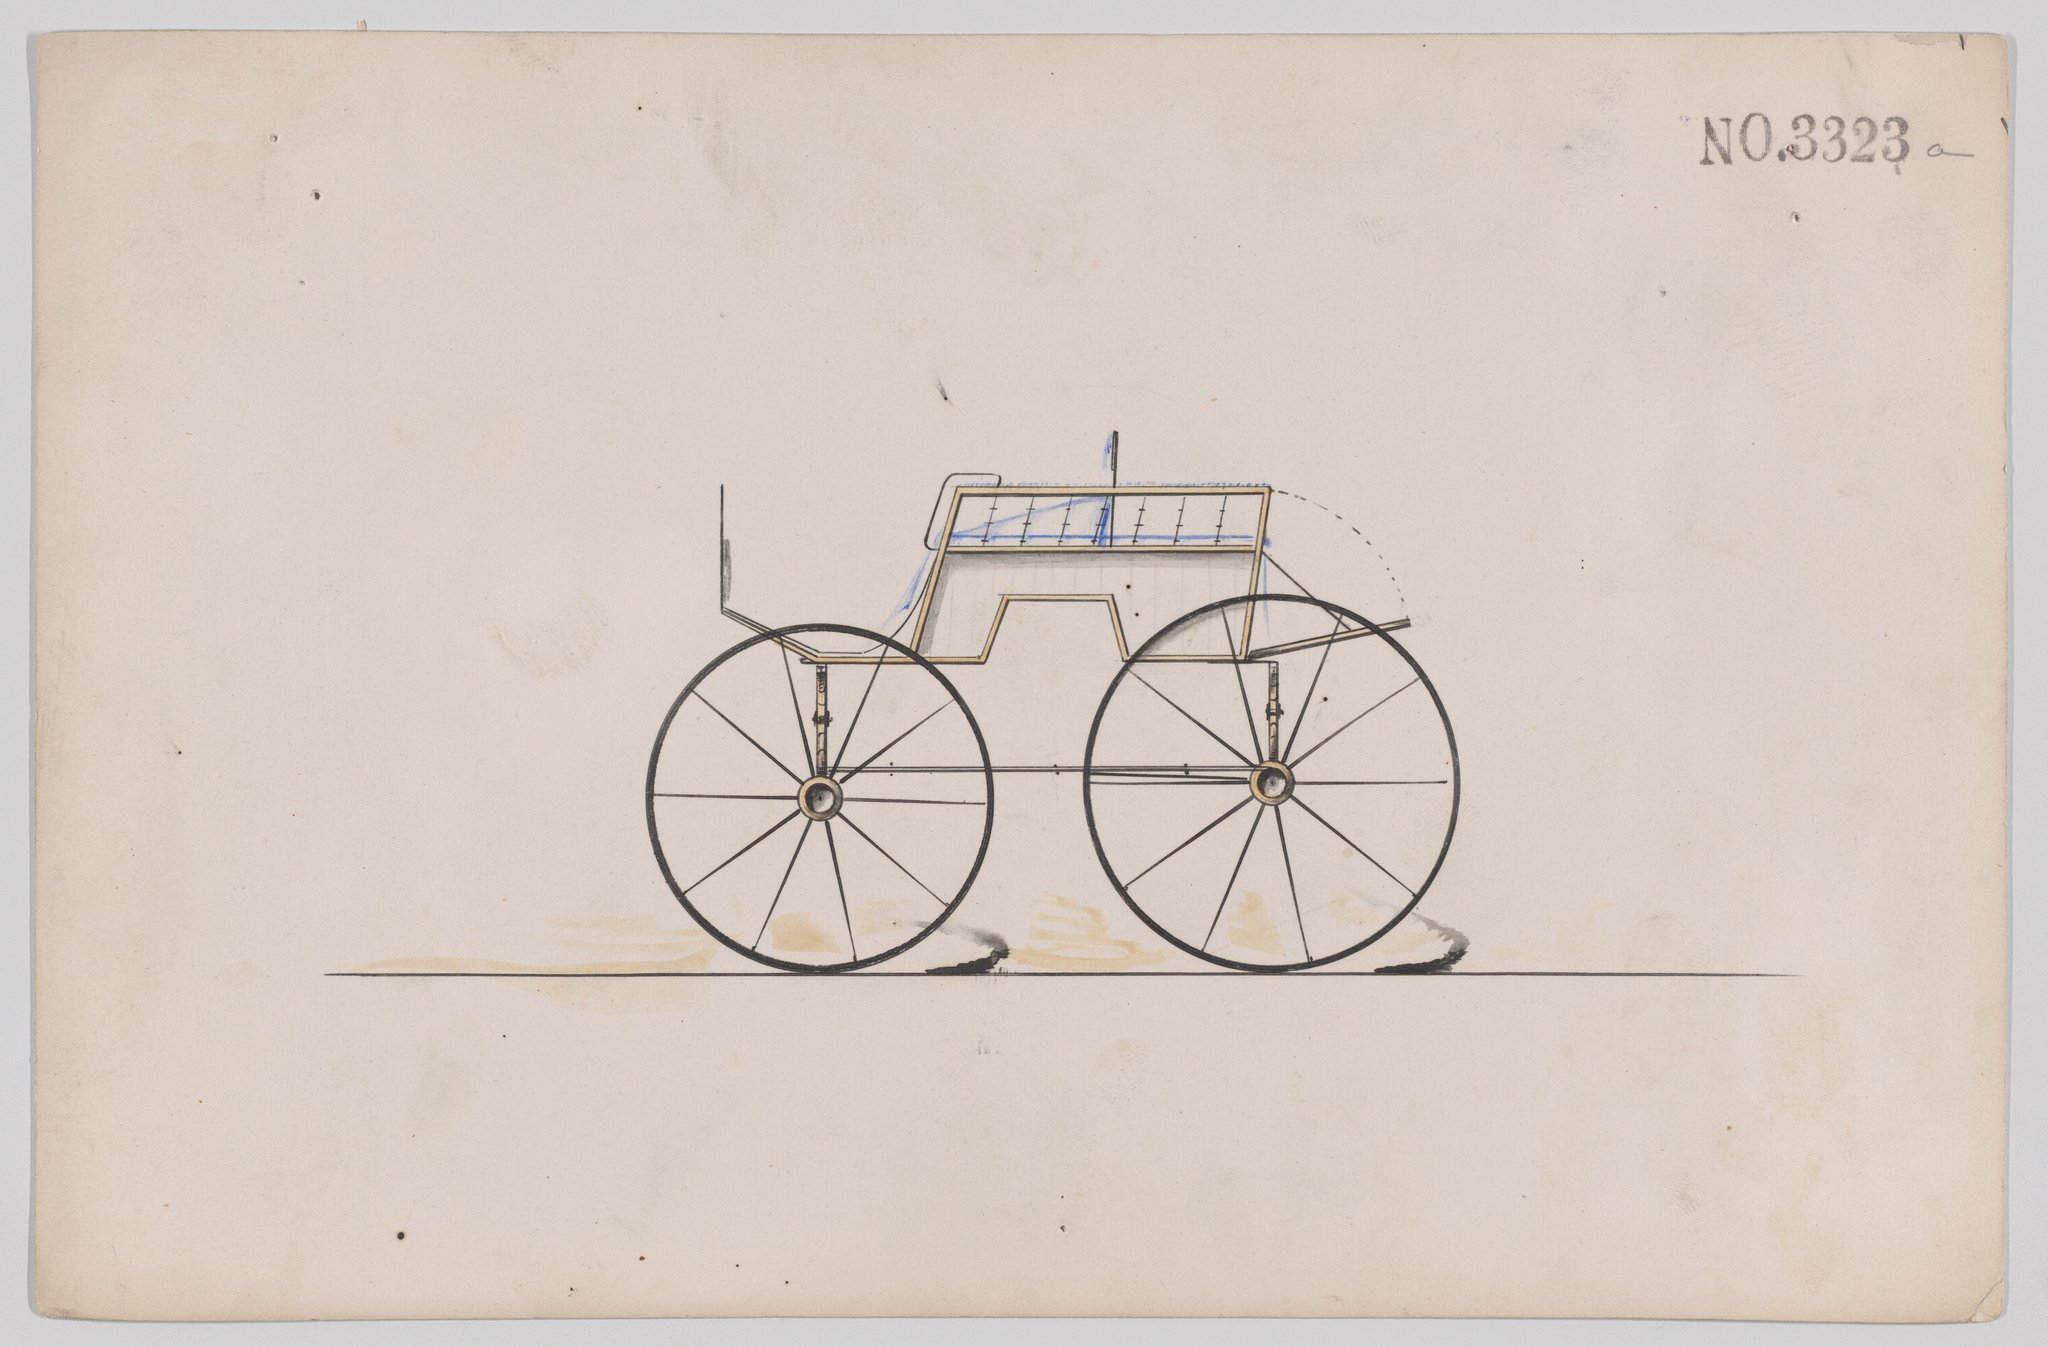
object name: drawing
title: Game Wagon # 3323a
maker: brewster & co.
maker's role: manufacturer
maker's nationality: american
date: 1877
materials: gouache, ink, watercolor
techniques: pen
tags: carriages